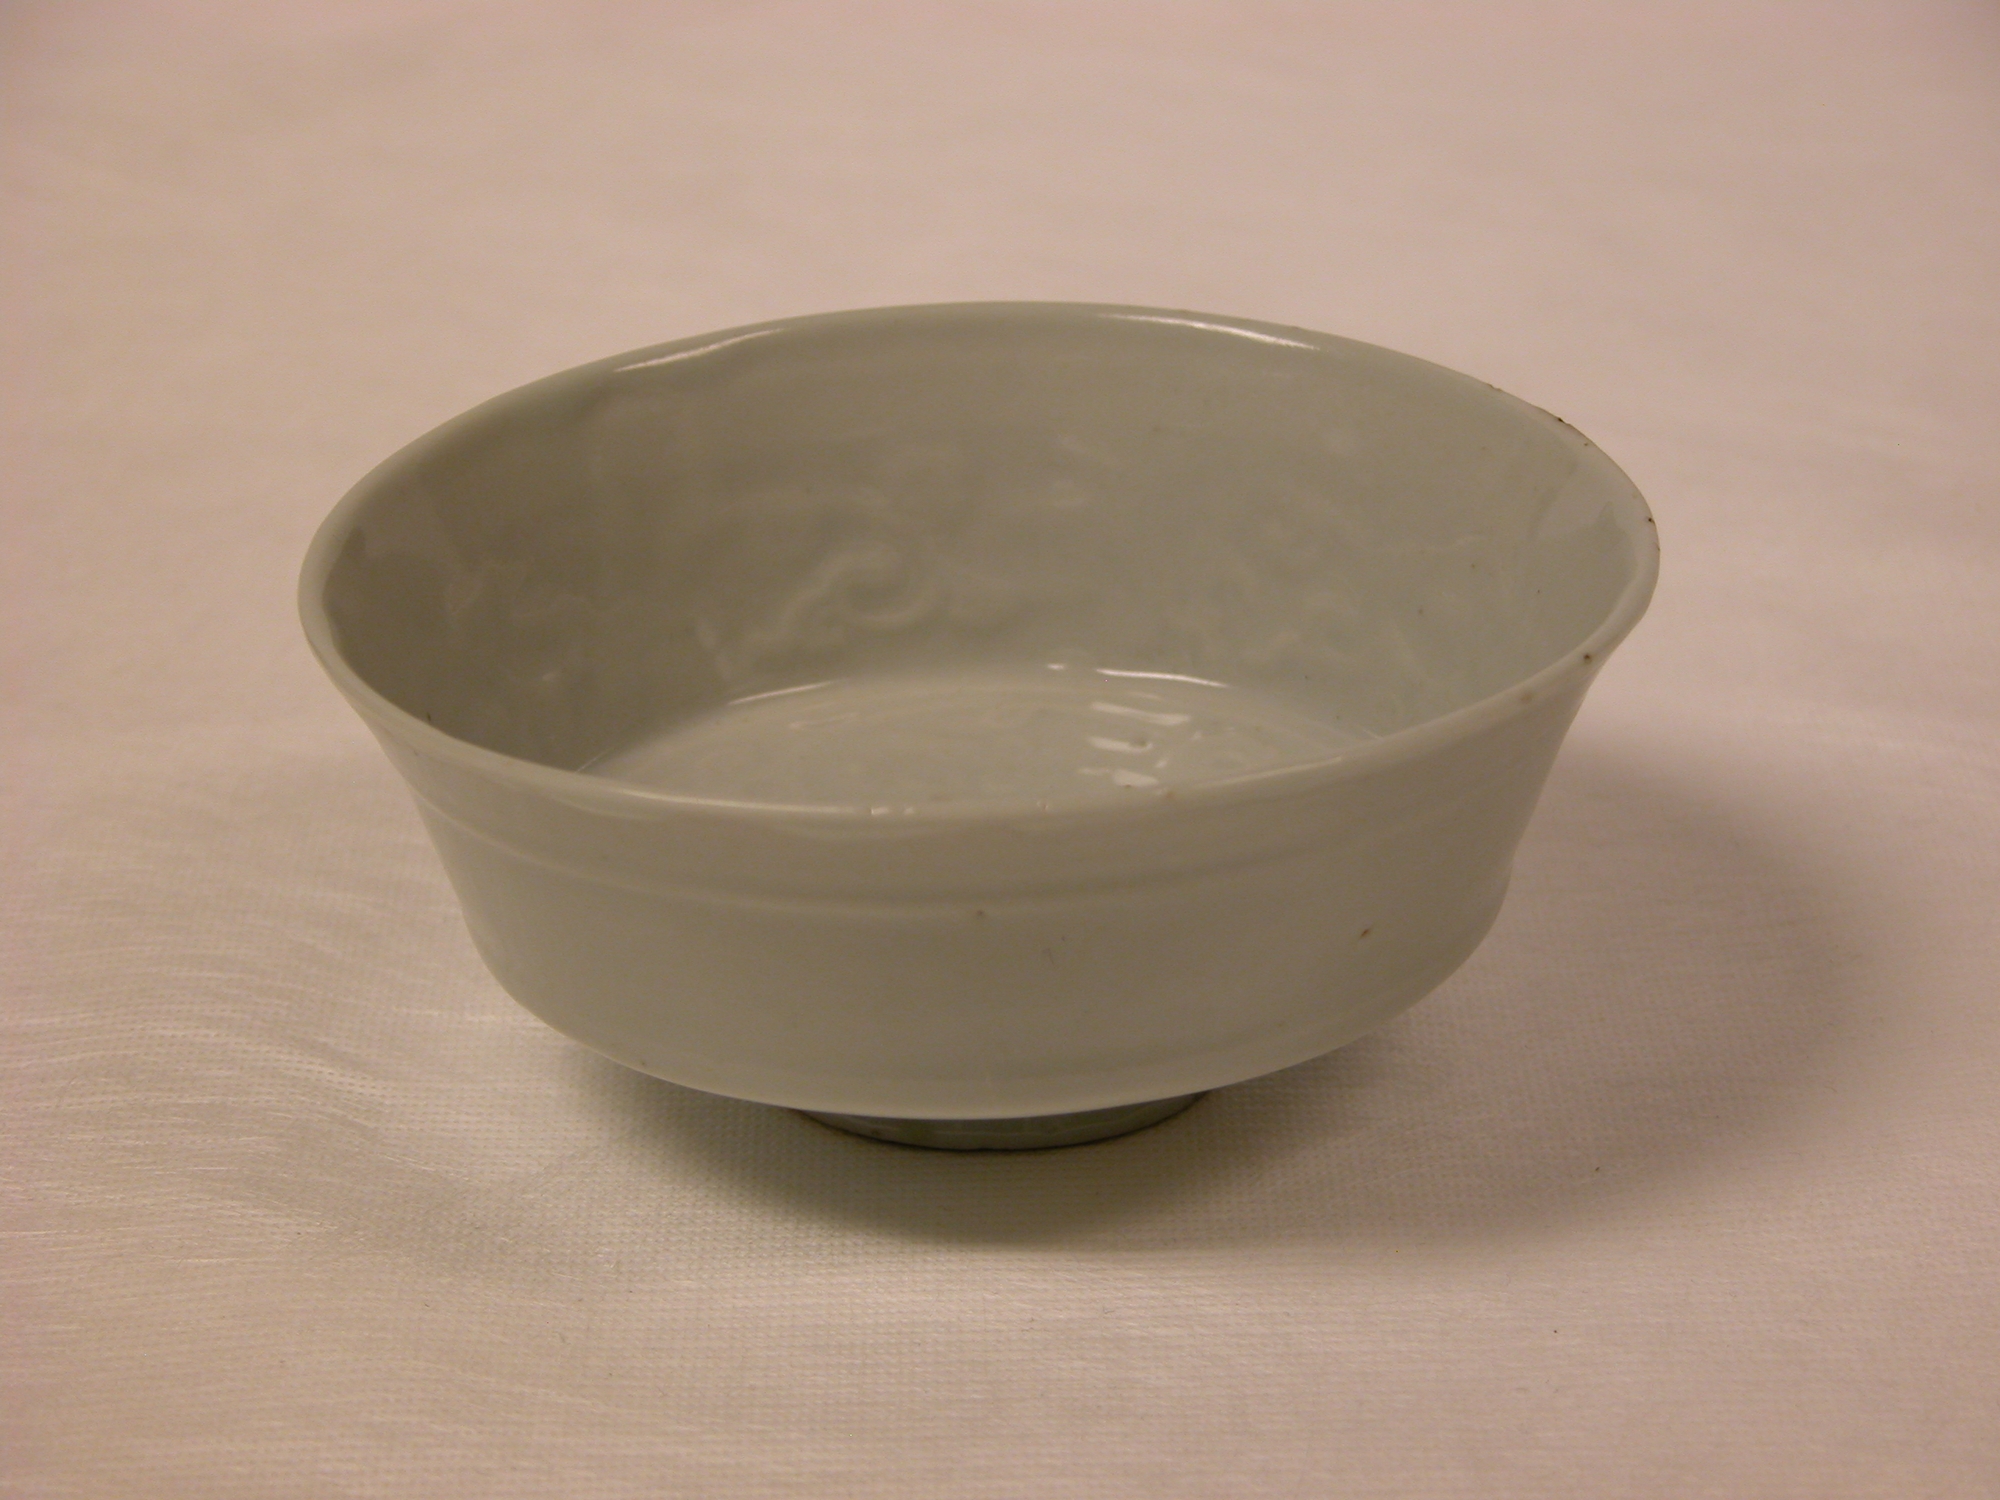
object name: dish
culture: chinese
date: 1271-1368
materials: porcelain